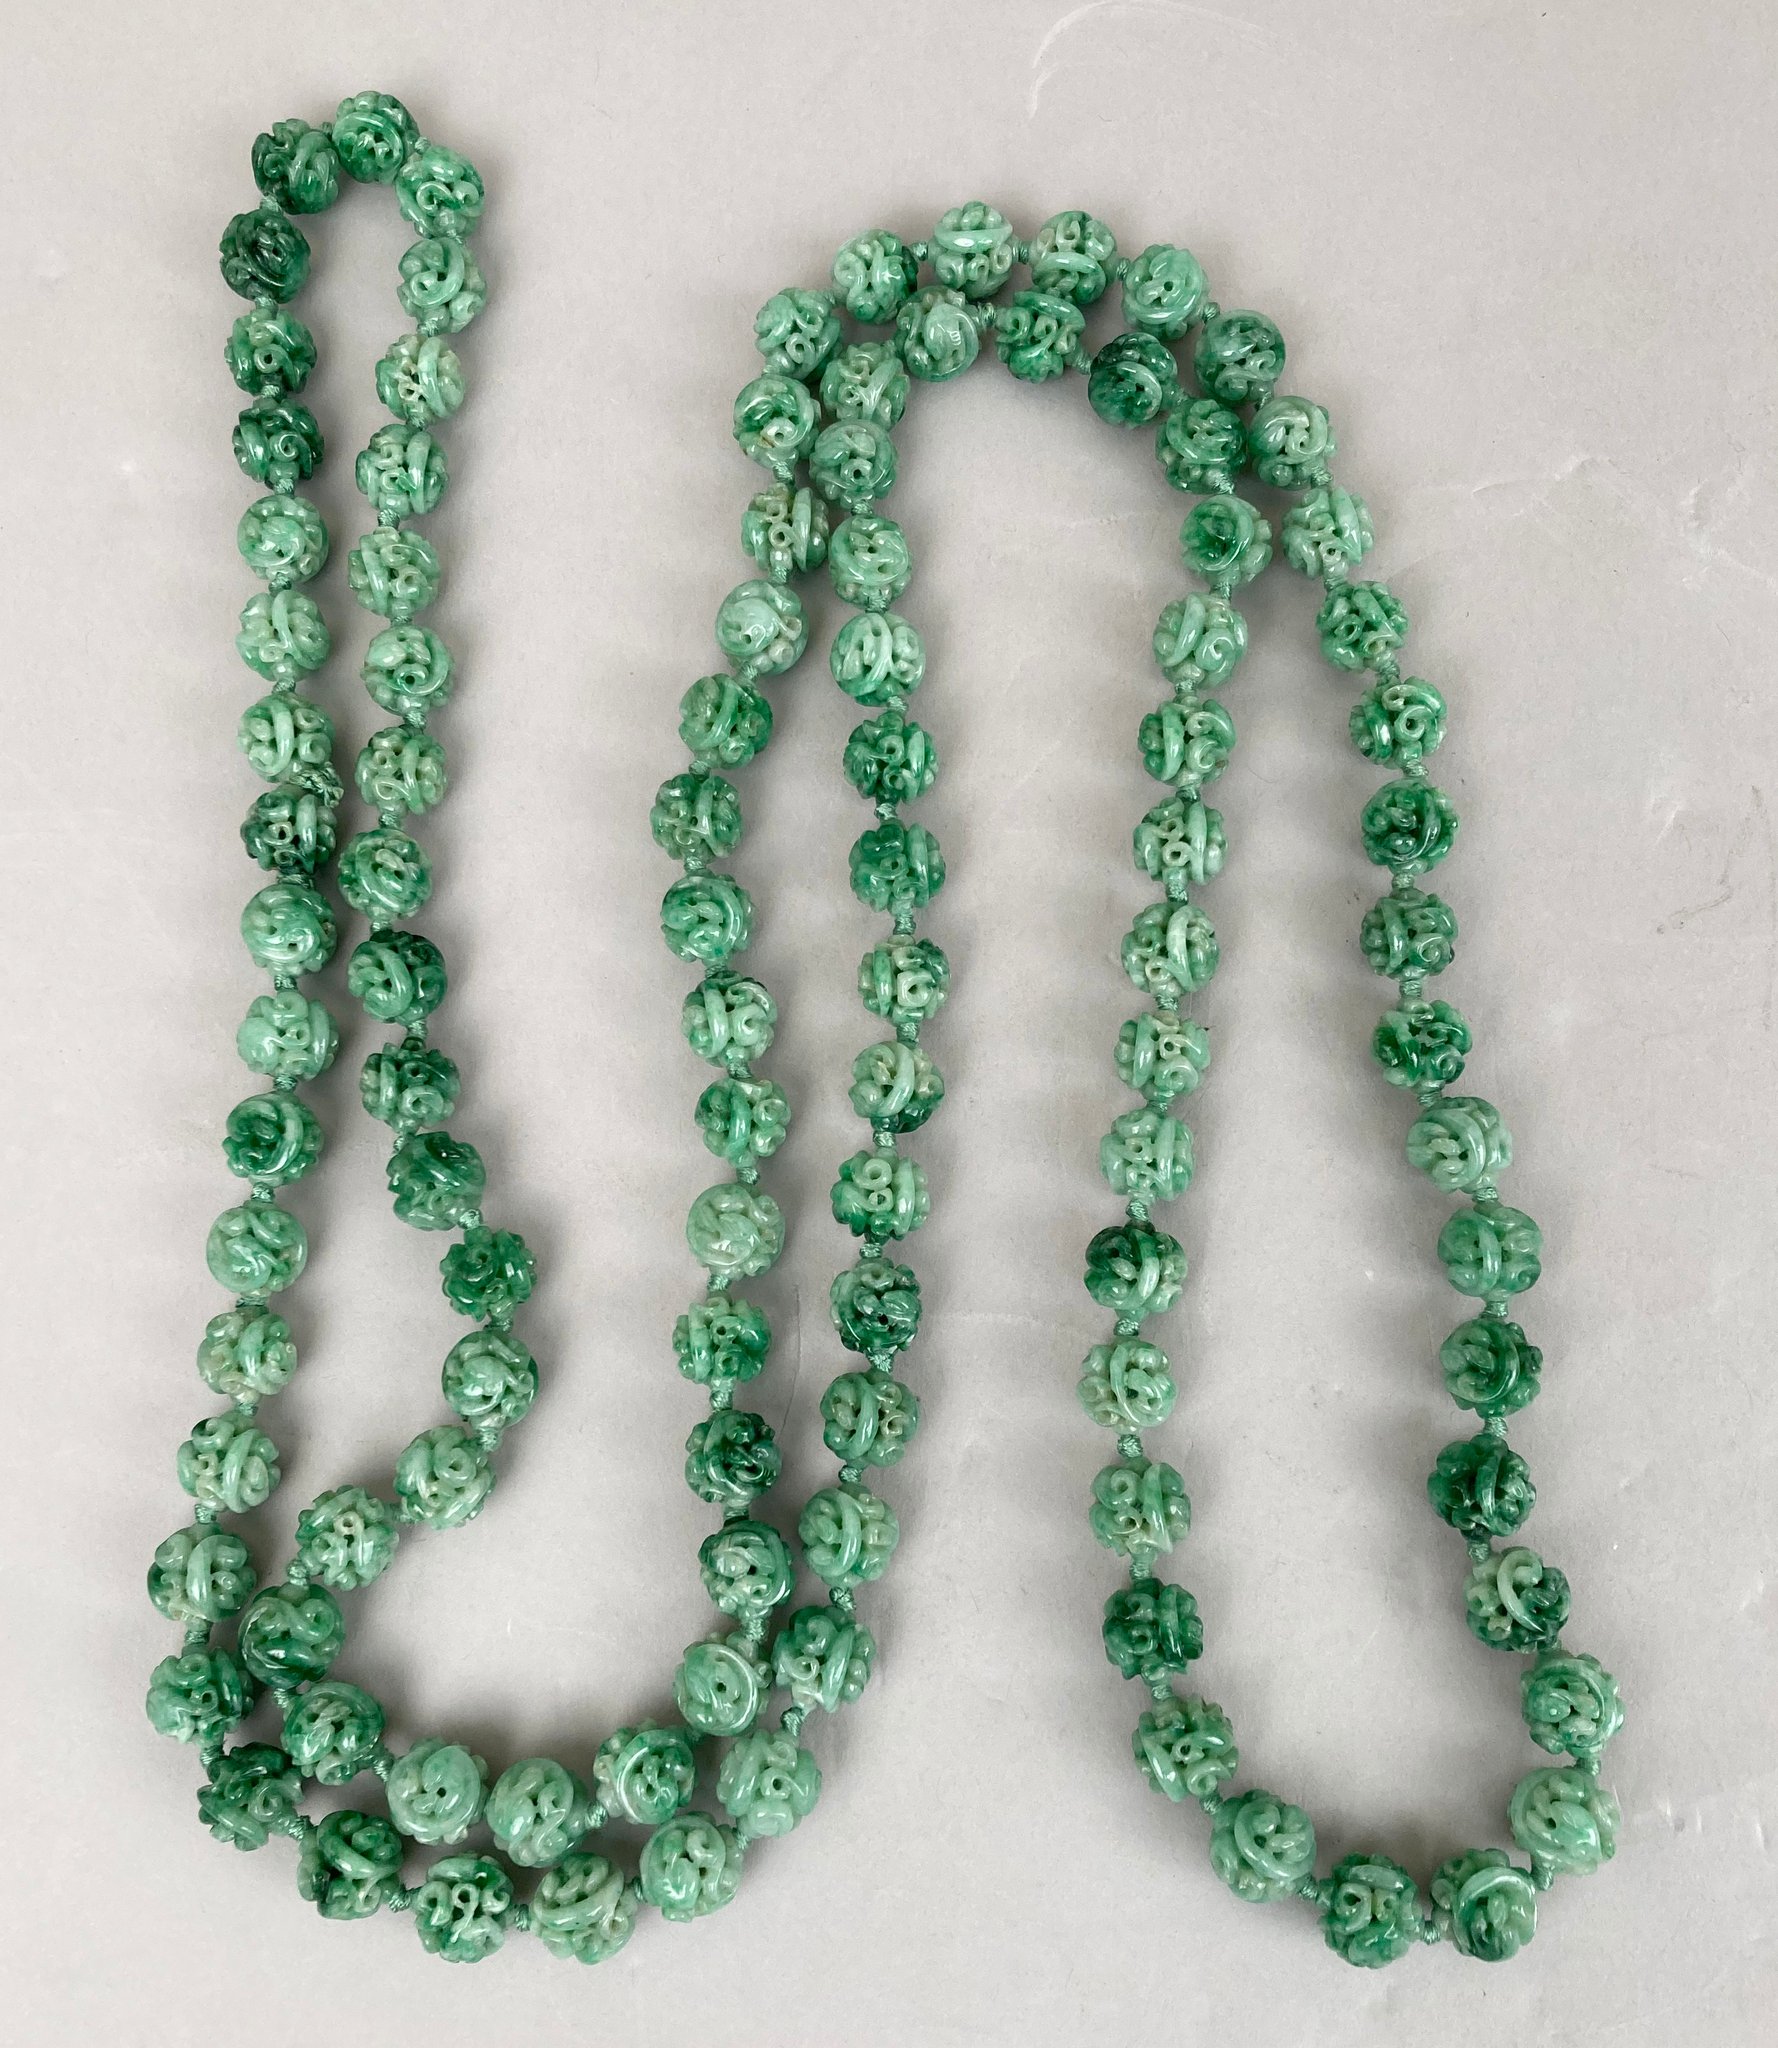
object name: necklace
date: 1801-1833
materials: jade